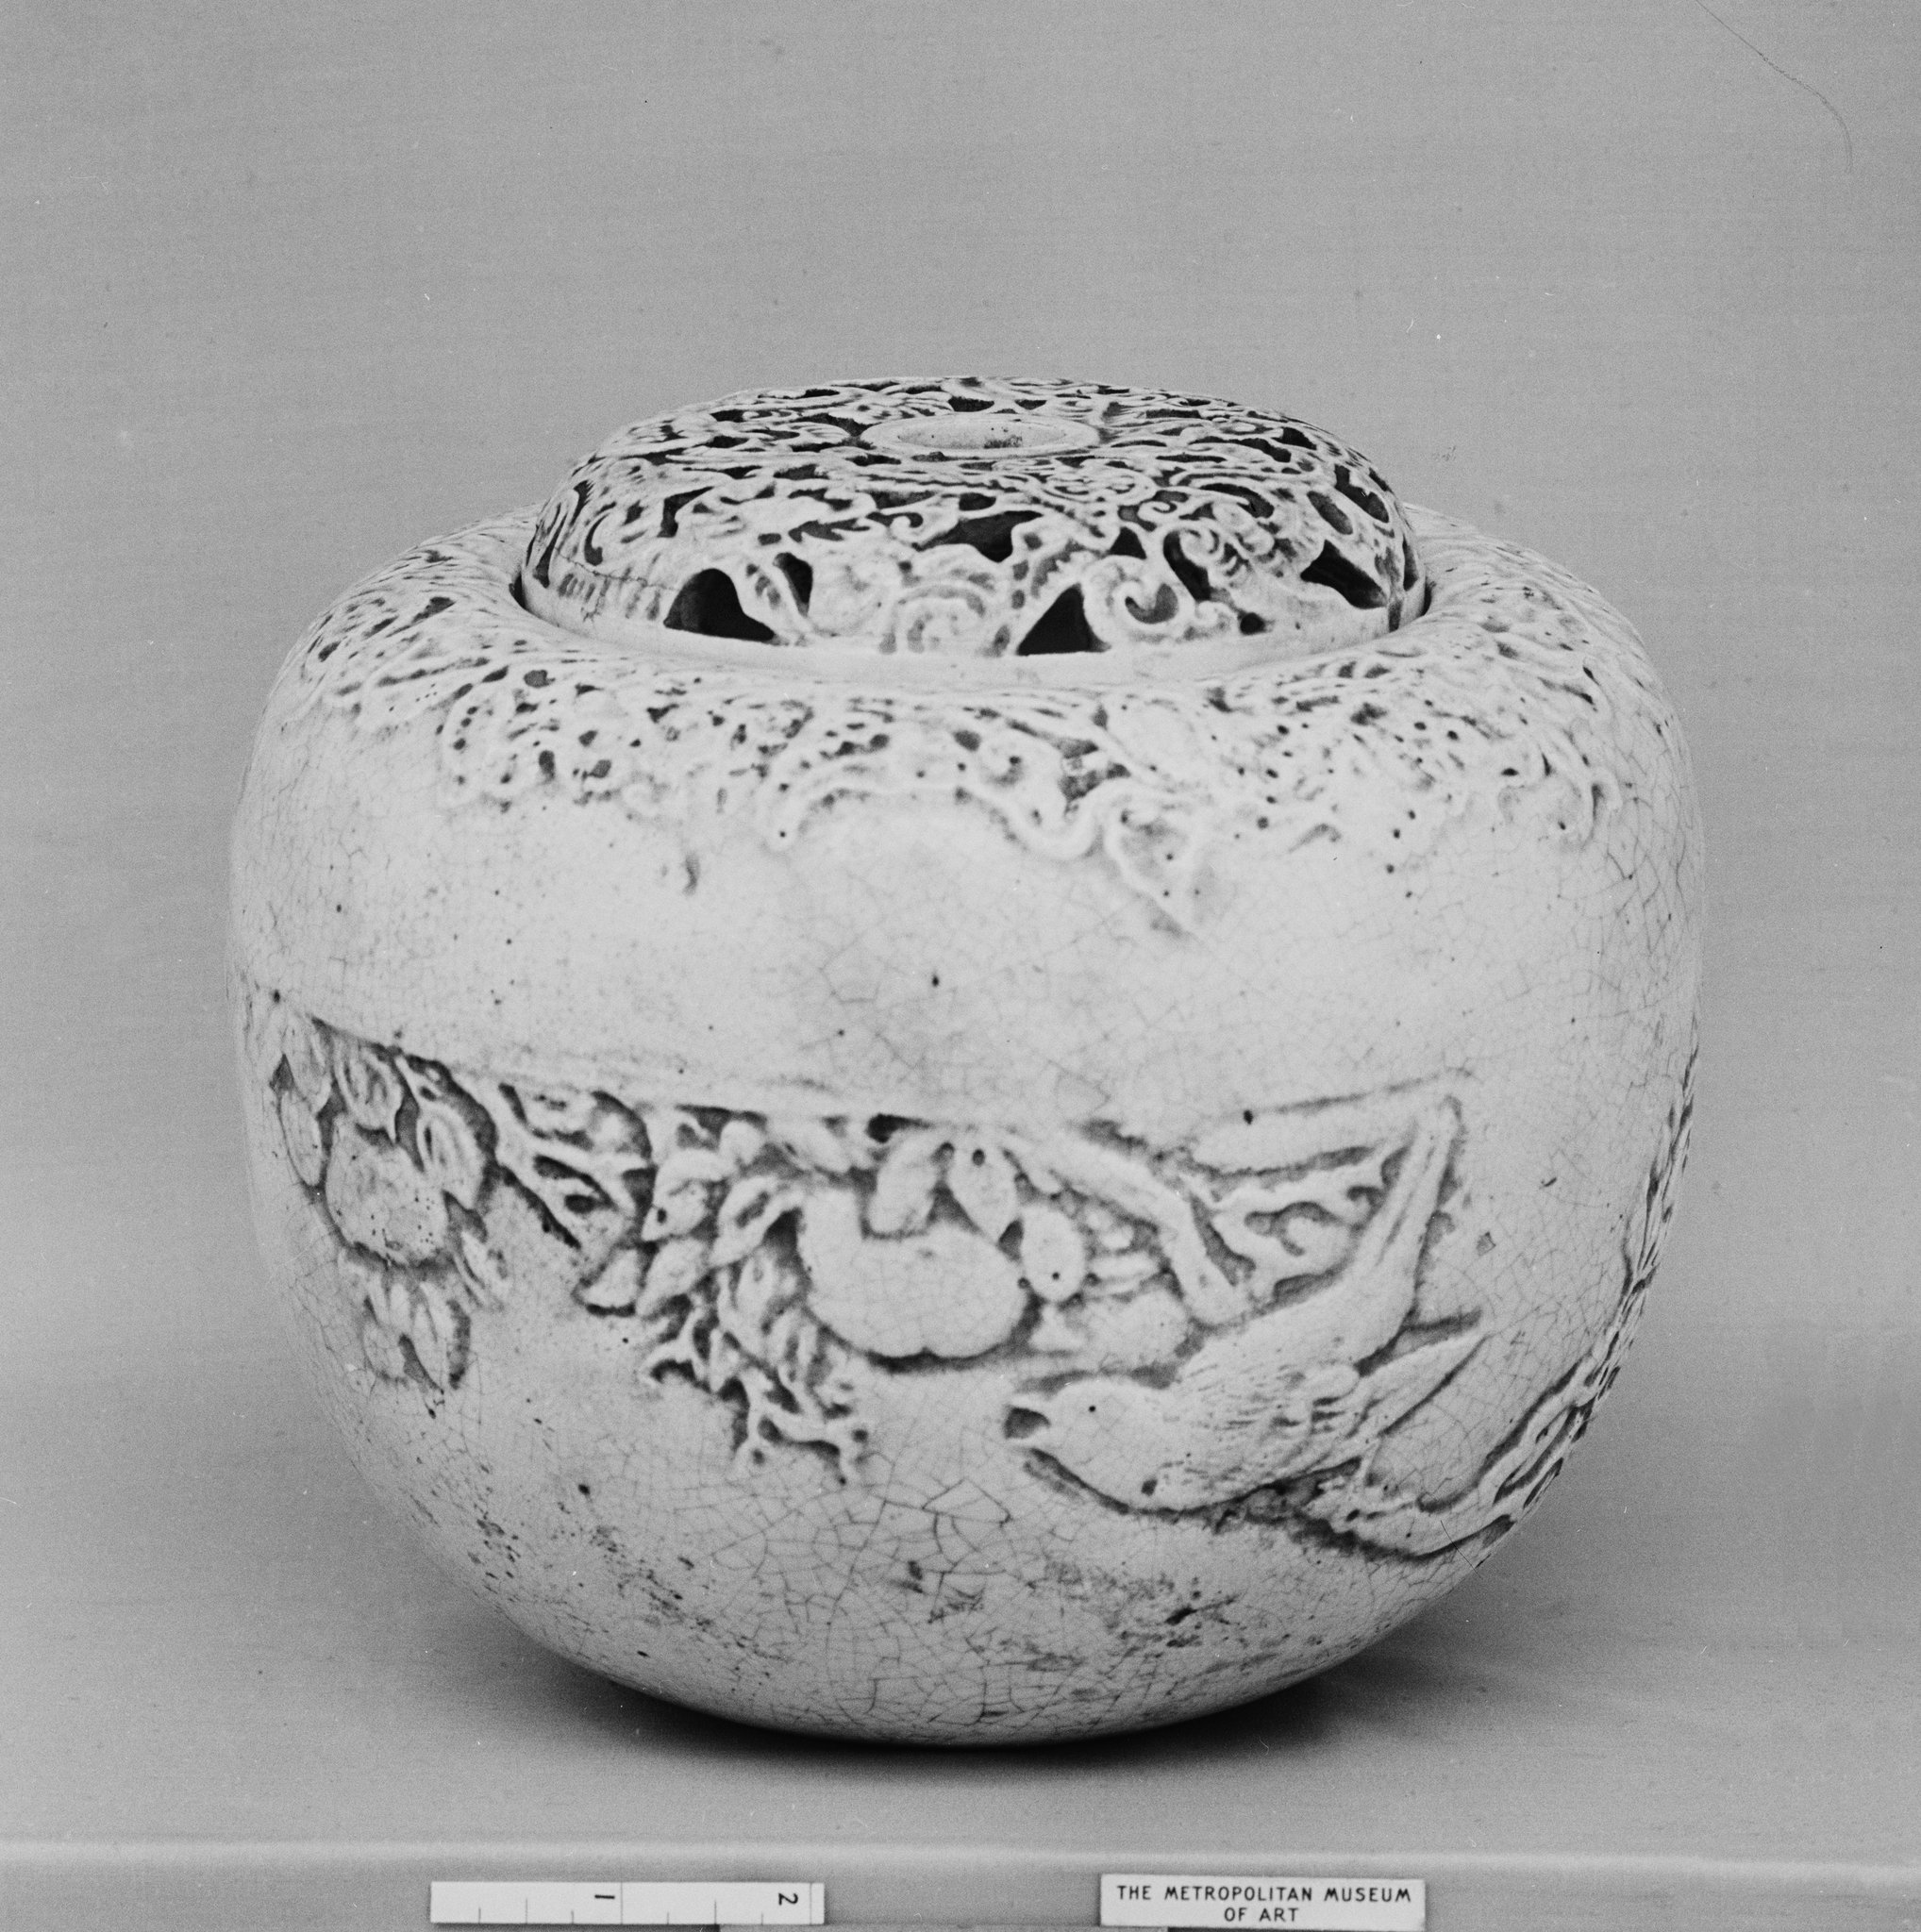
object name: mosquito smoker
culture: japanese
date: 1801-1900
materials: glaze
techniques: molding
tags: birds